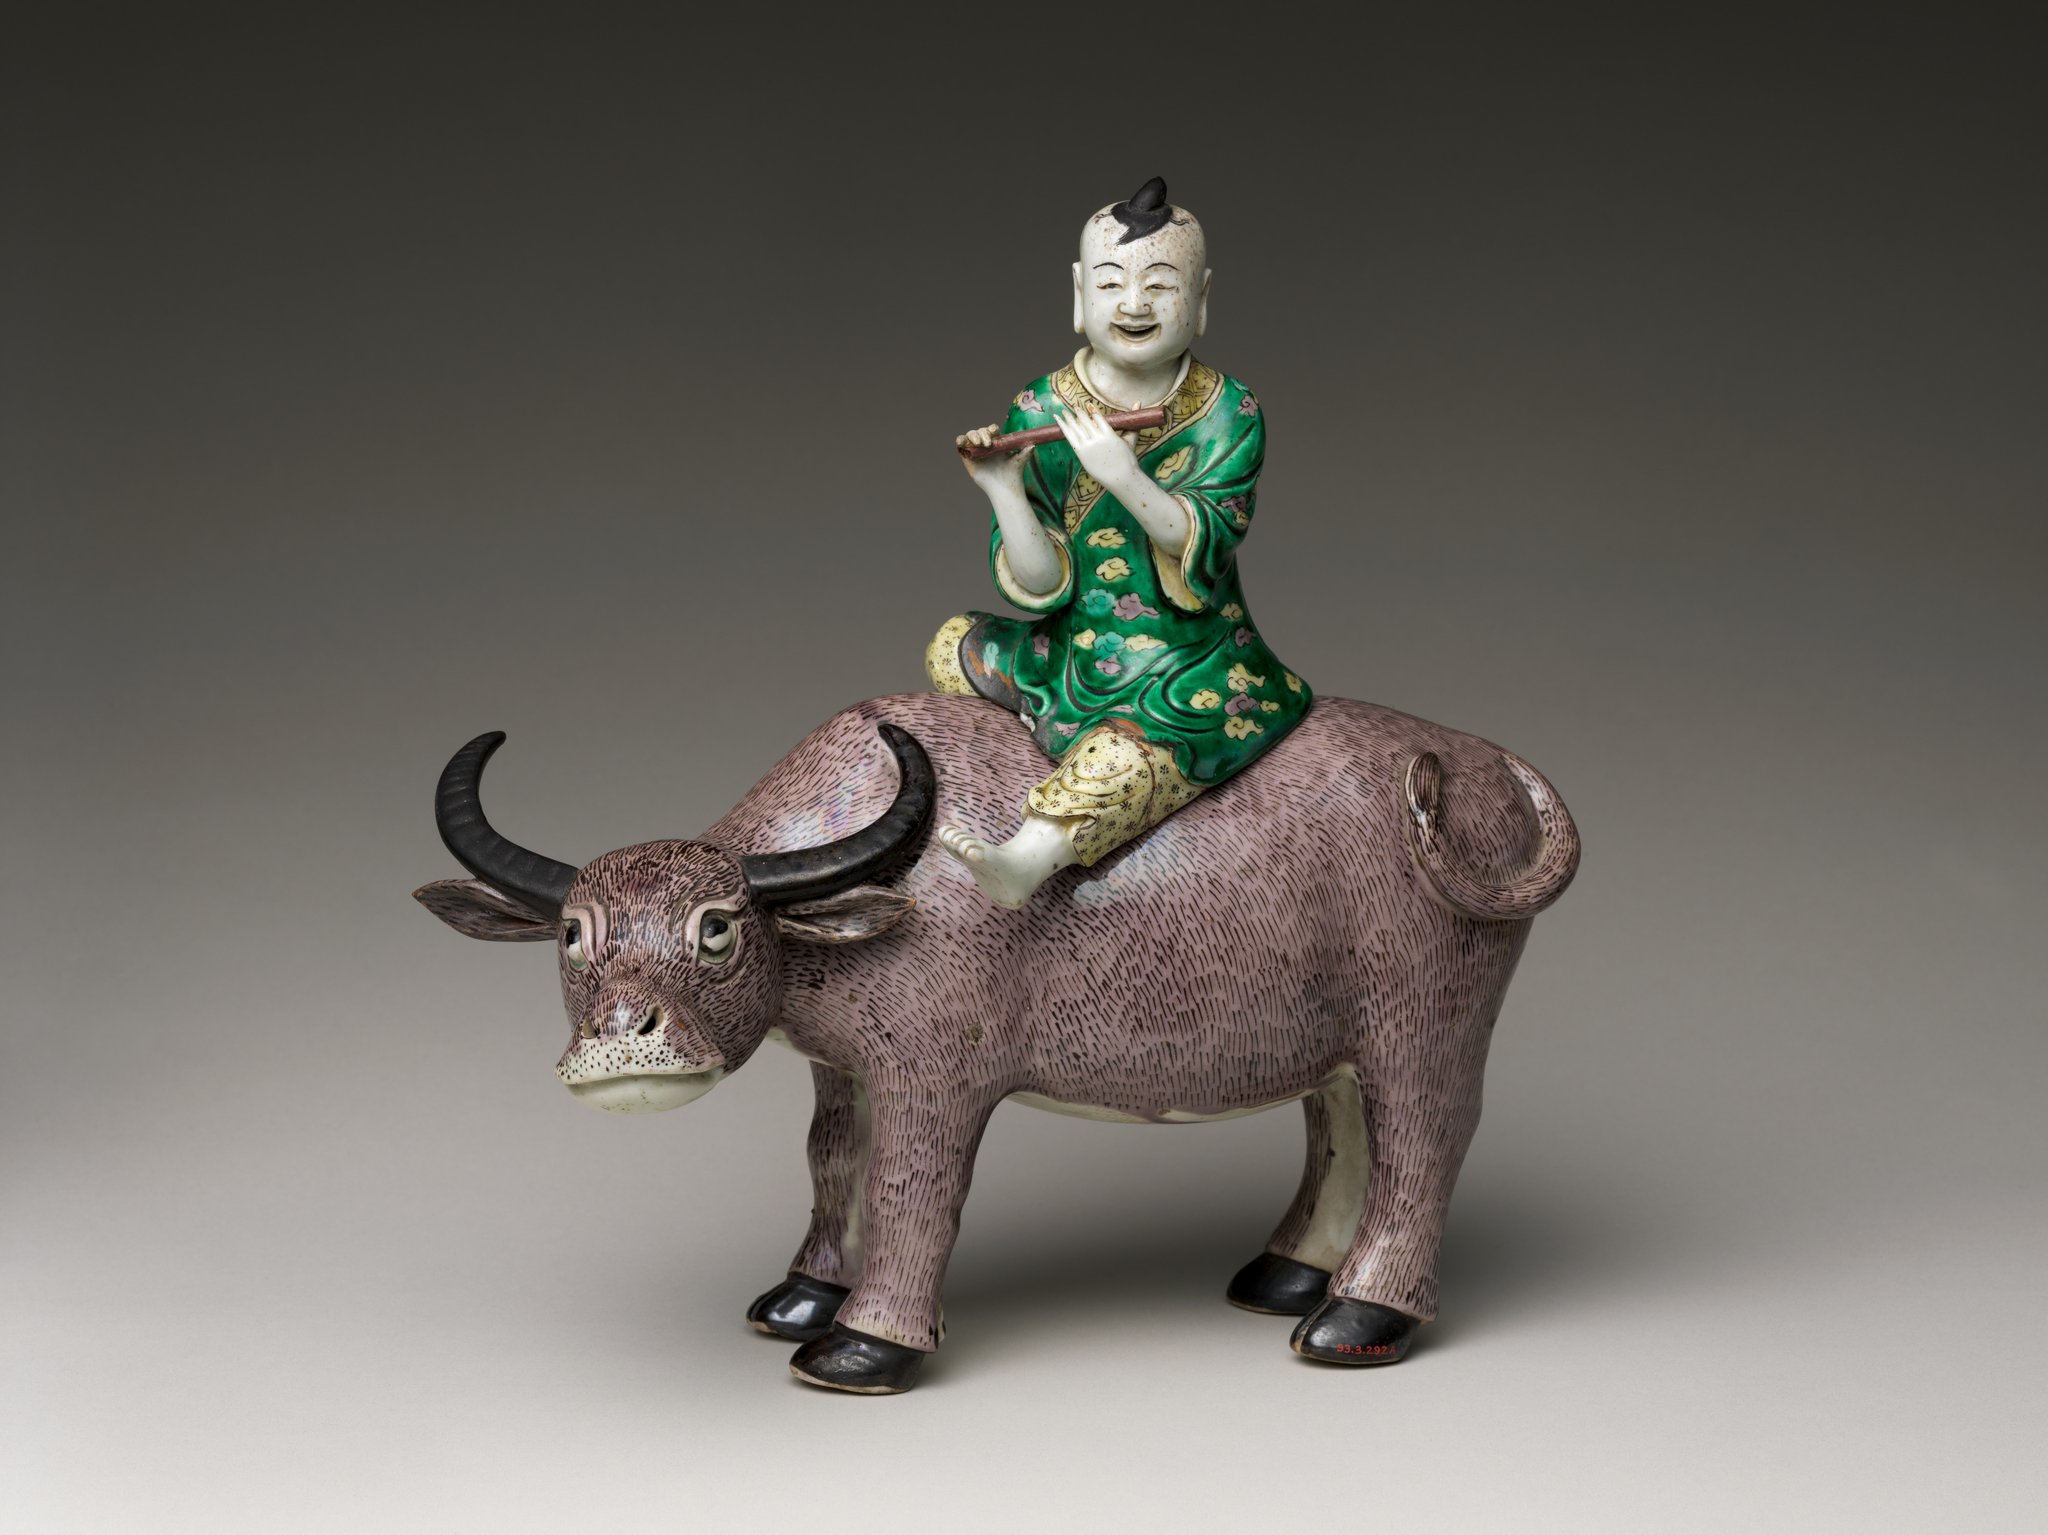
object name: figure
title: Herdboy Riding a Water Buffalo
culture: chinese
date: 1667-1733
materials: biscuit, enamel, porcelain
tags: boys,buffalos